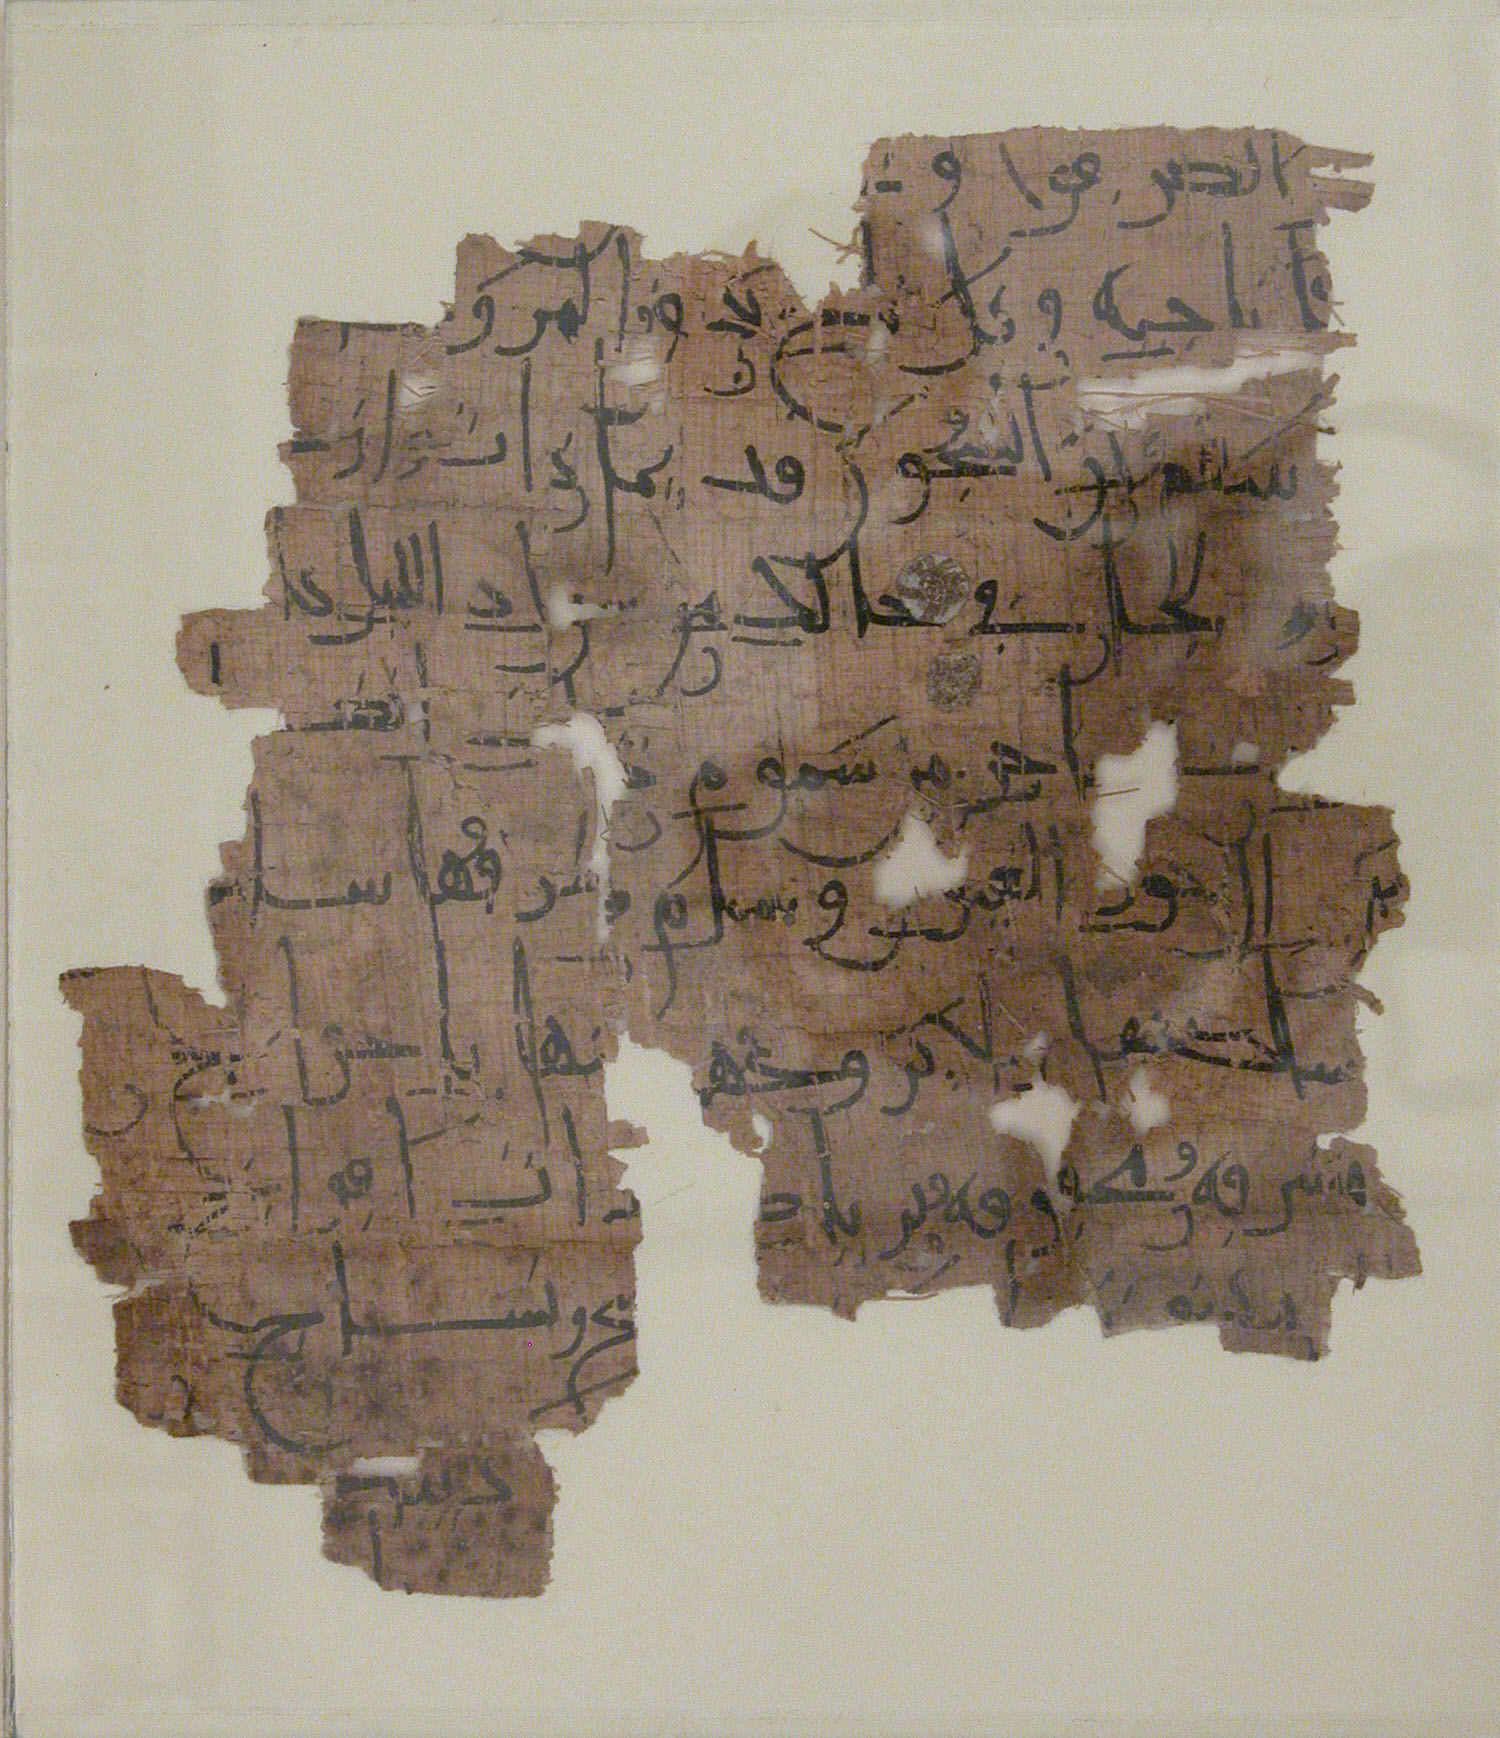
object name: fragment of a non illustrated single work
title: Papyrus Fragment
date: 1001-1200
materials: ink, papyrus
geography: egypt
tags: calligraphy